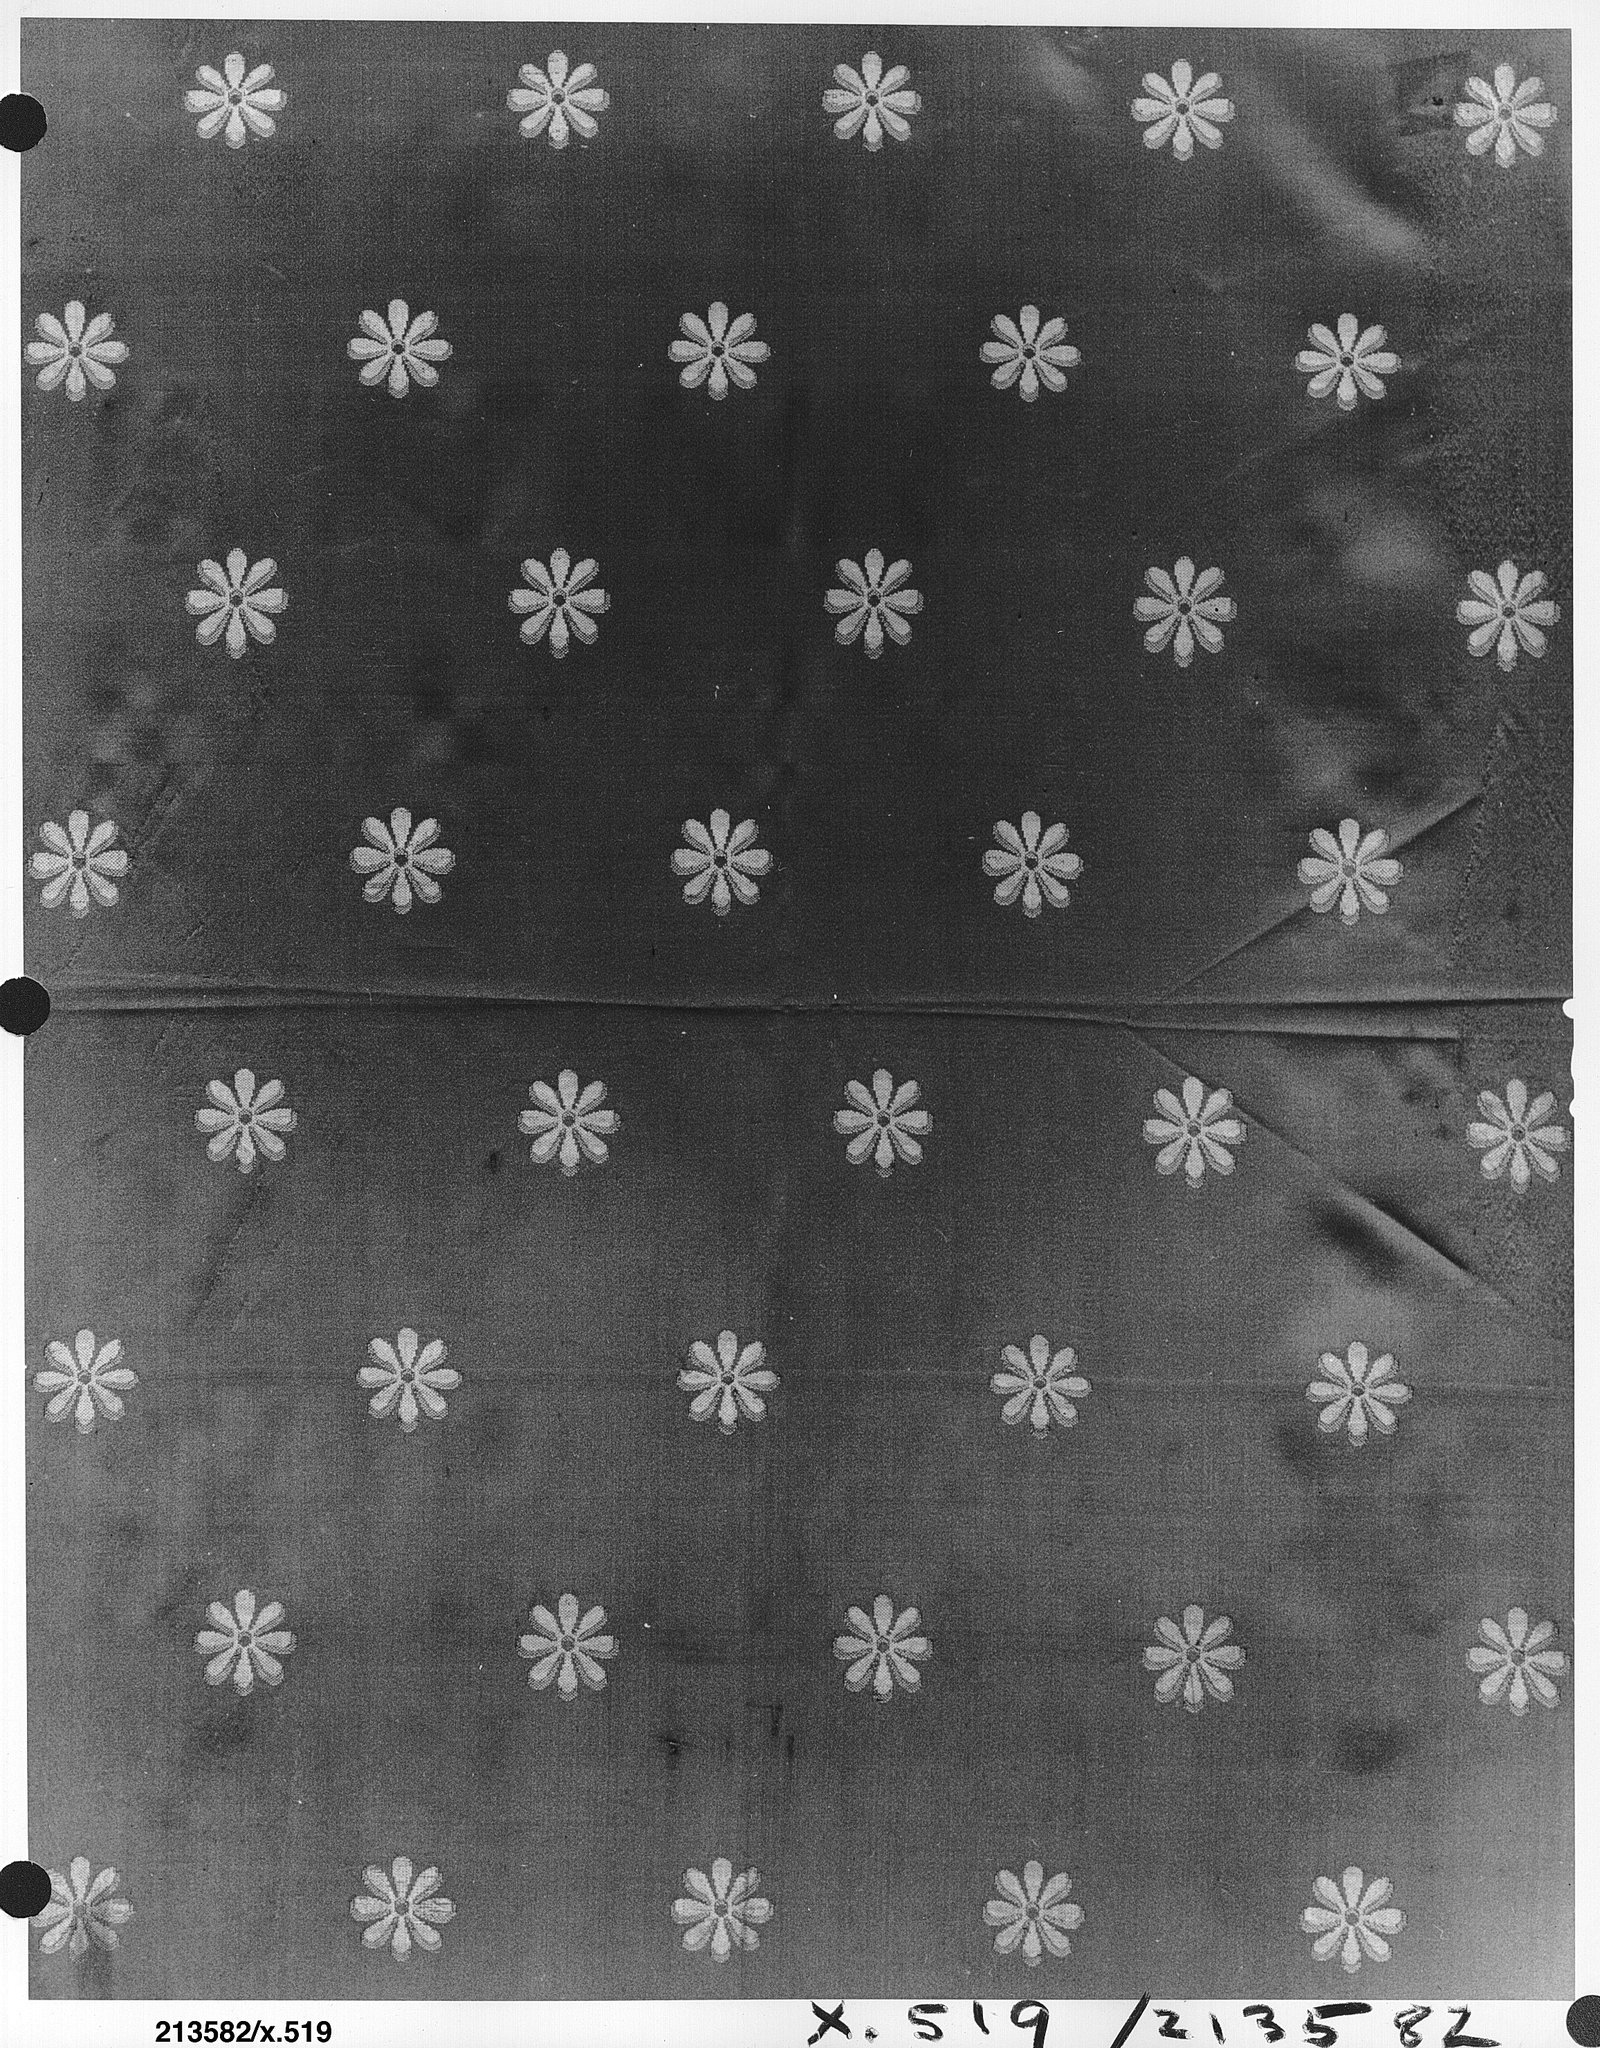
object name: piece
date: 1801-1833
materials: silk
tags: flowers